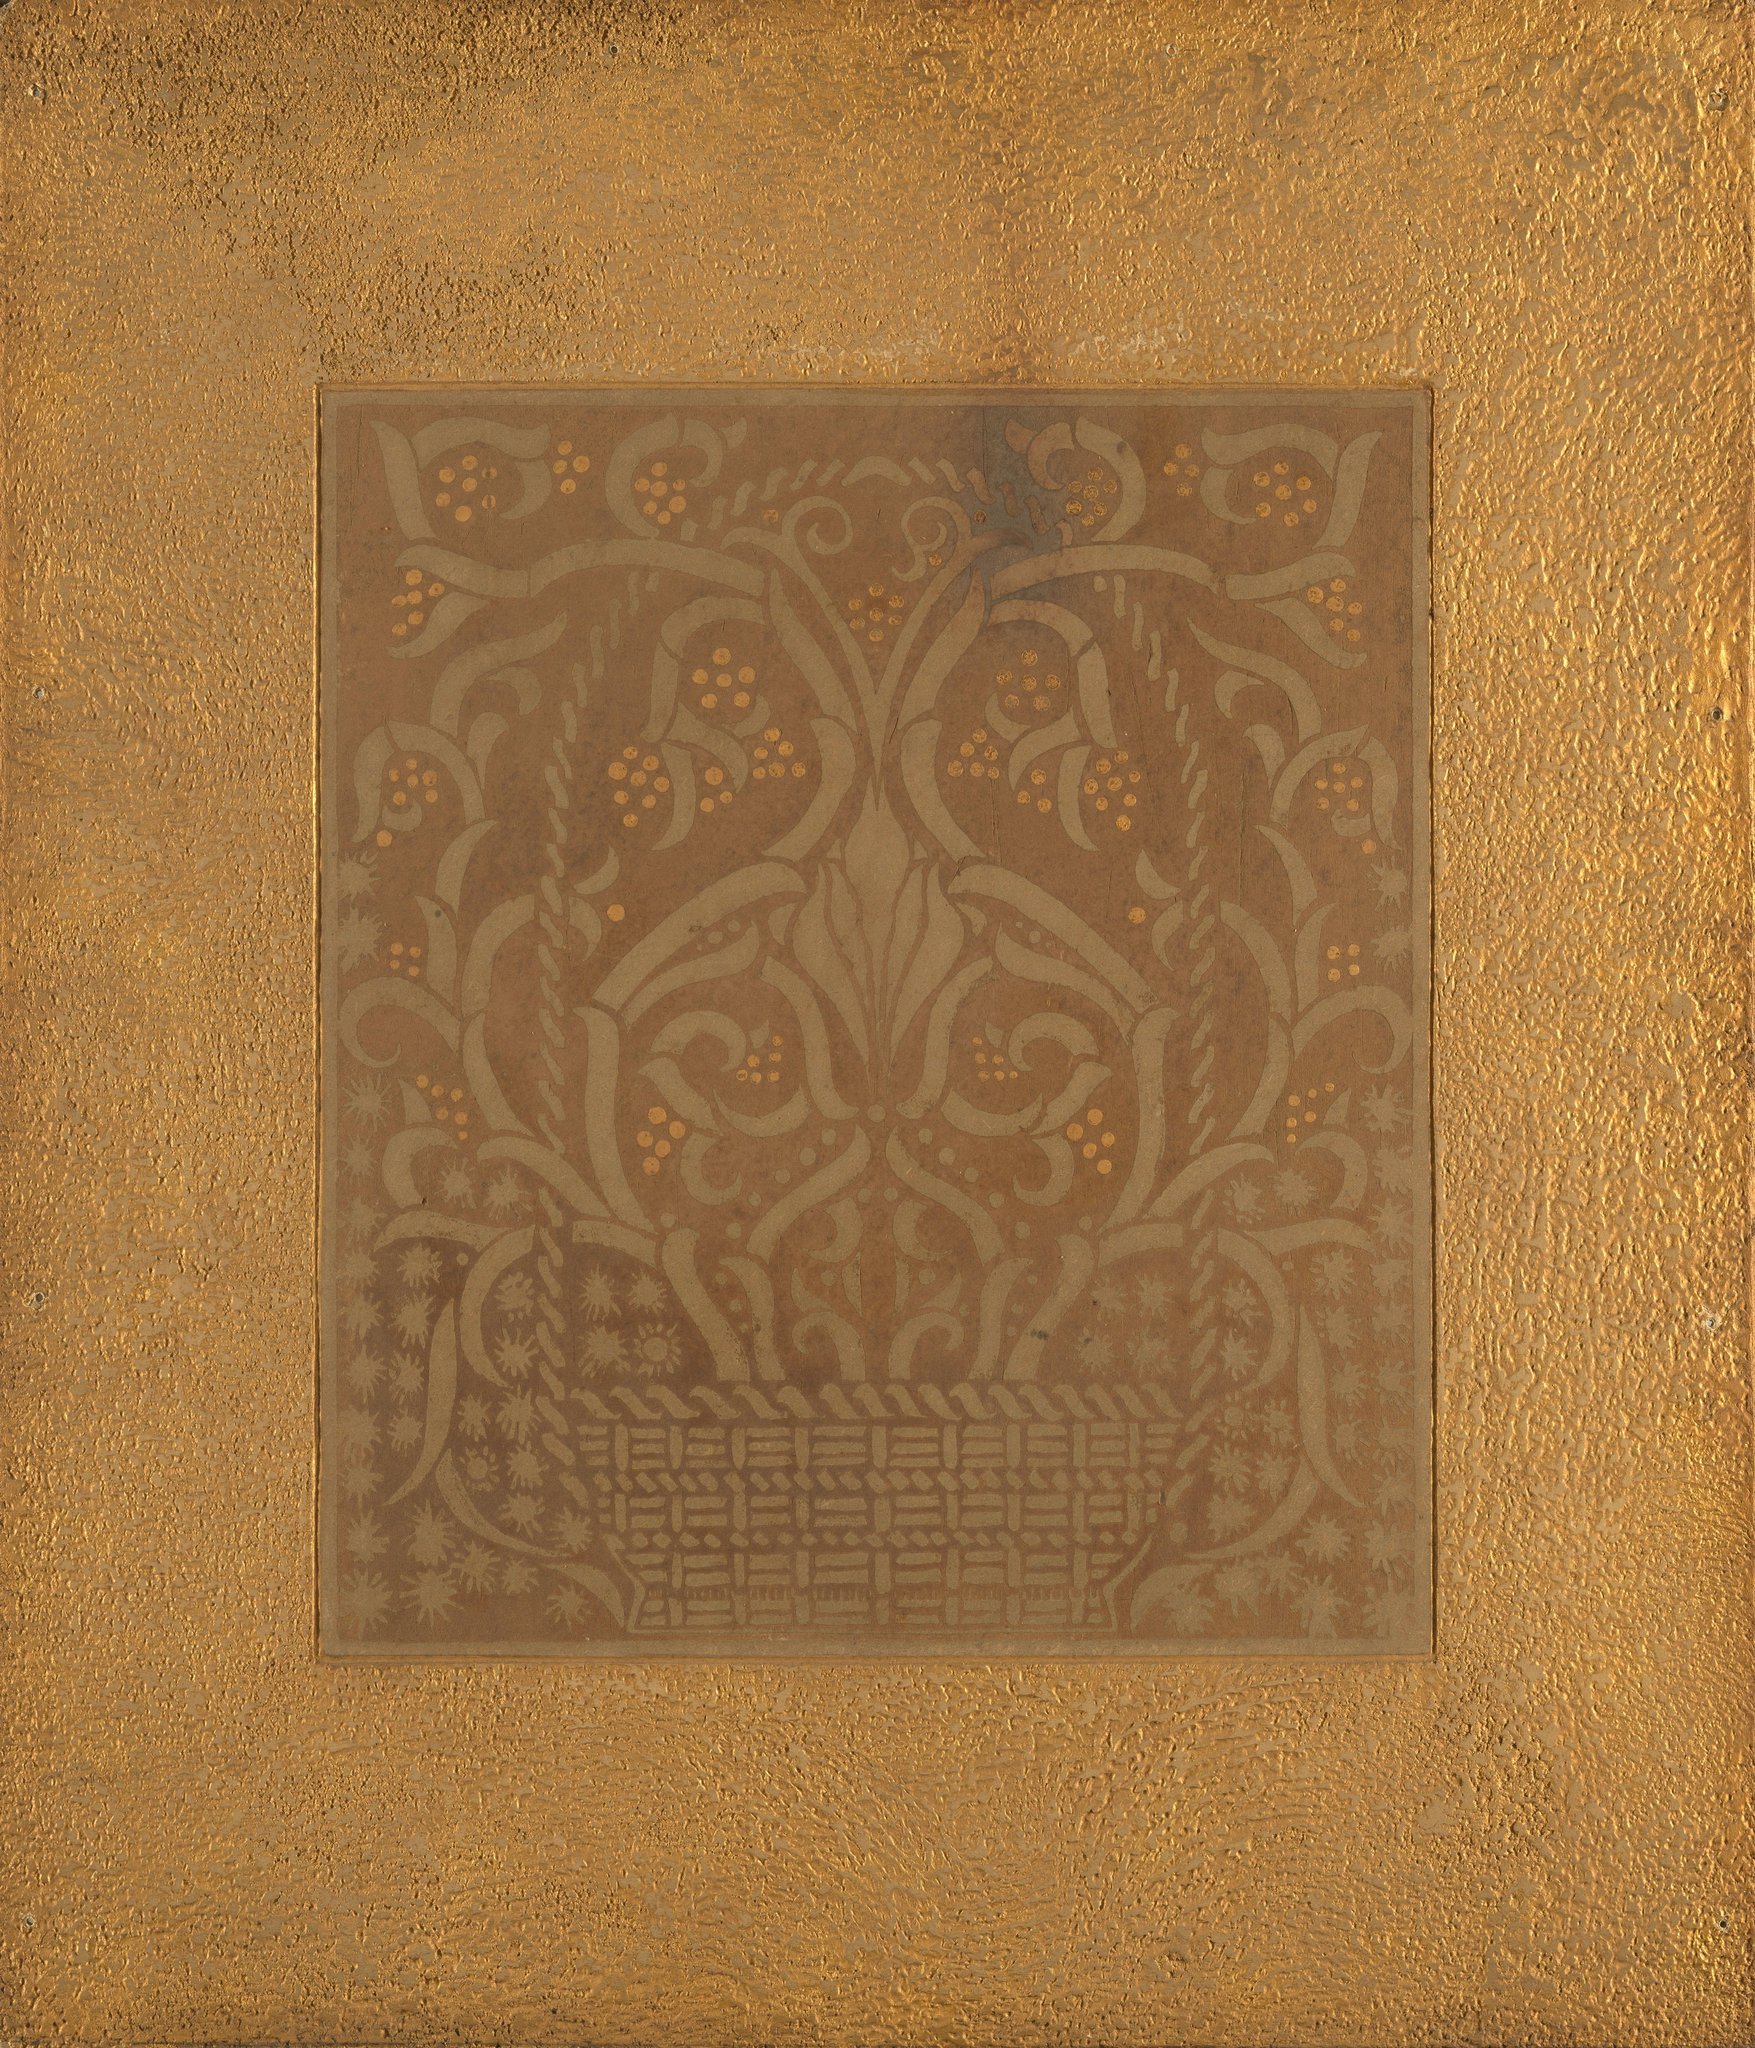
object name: furniture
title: Stuk asbest, versierd met een gestileerde mand met bloemen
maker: Anonymous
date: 1900-1920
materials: asbestos, paint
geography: netherlands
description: Stuk asbest, versierd met een gestileerde mand met bloemen in de kleuren bruin, grijs, wit en goud.